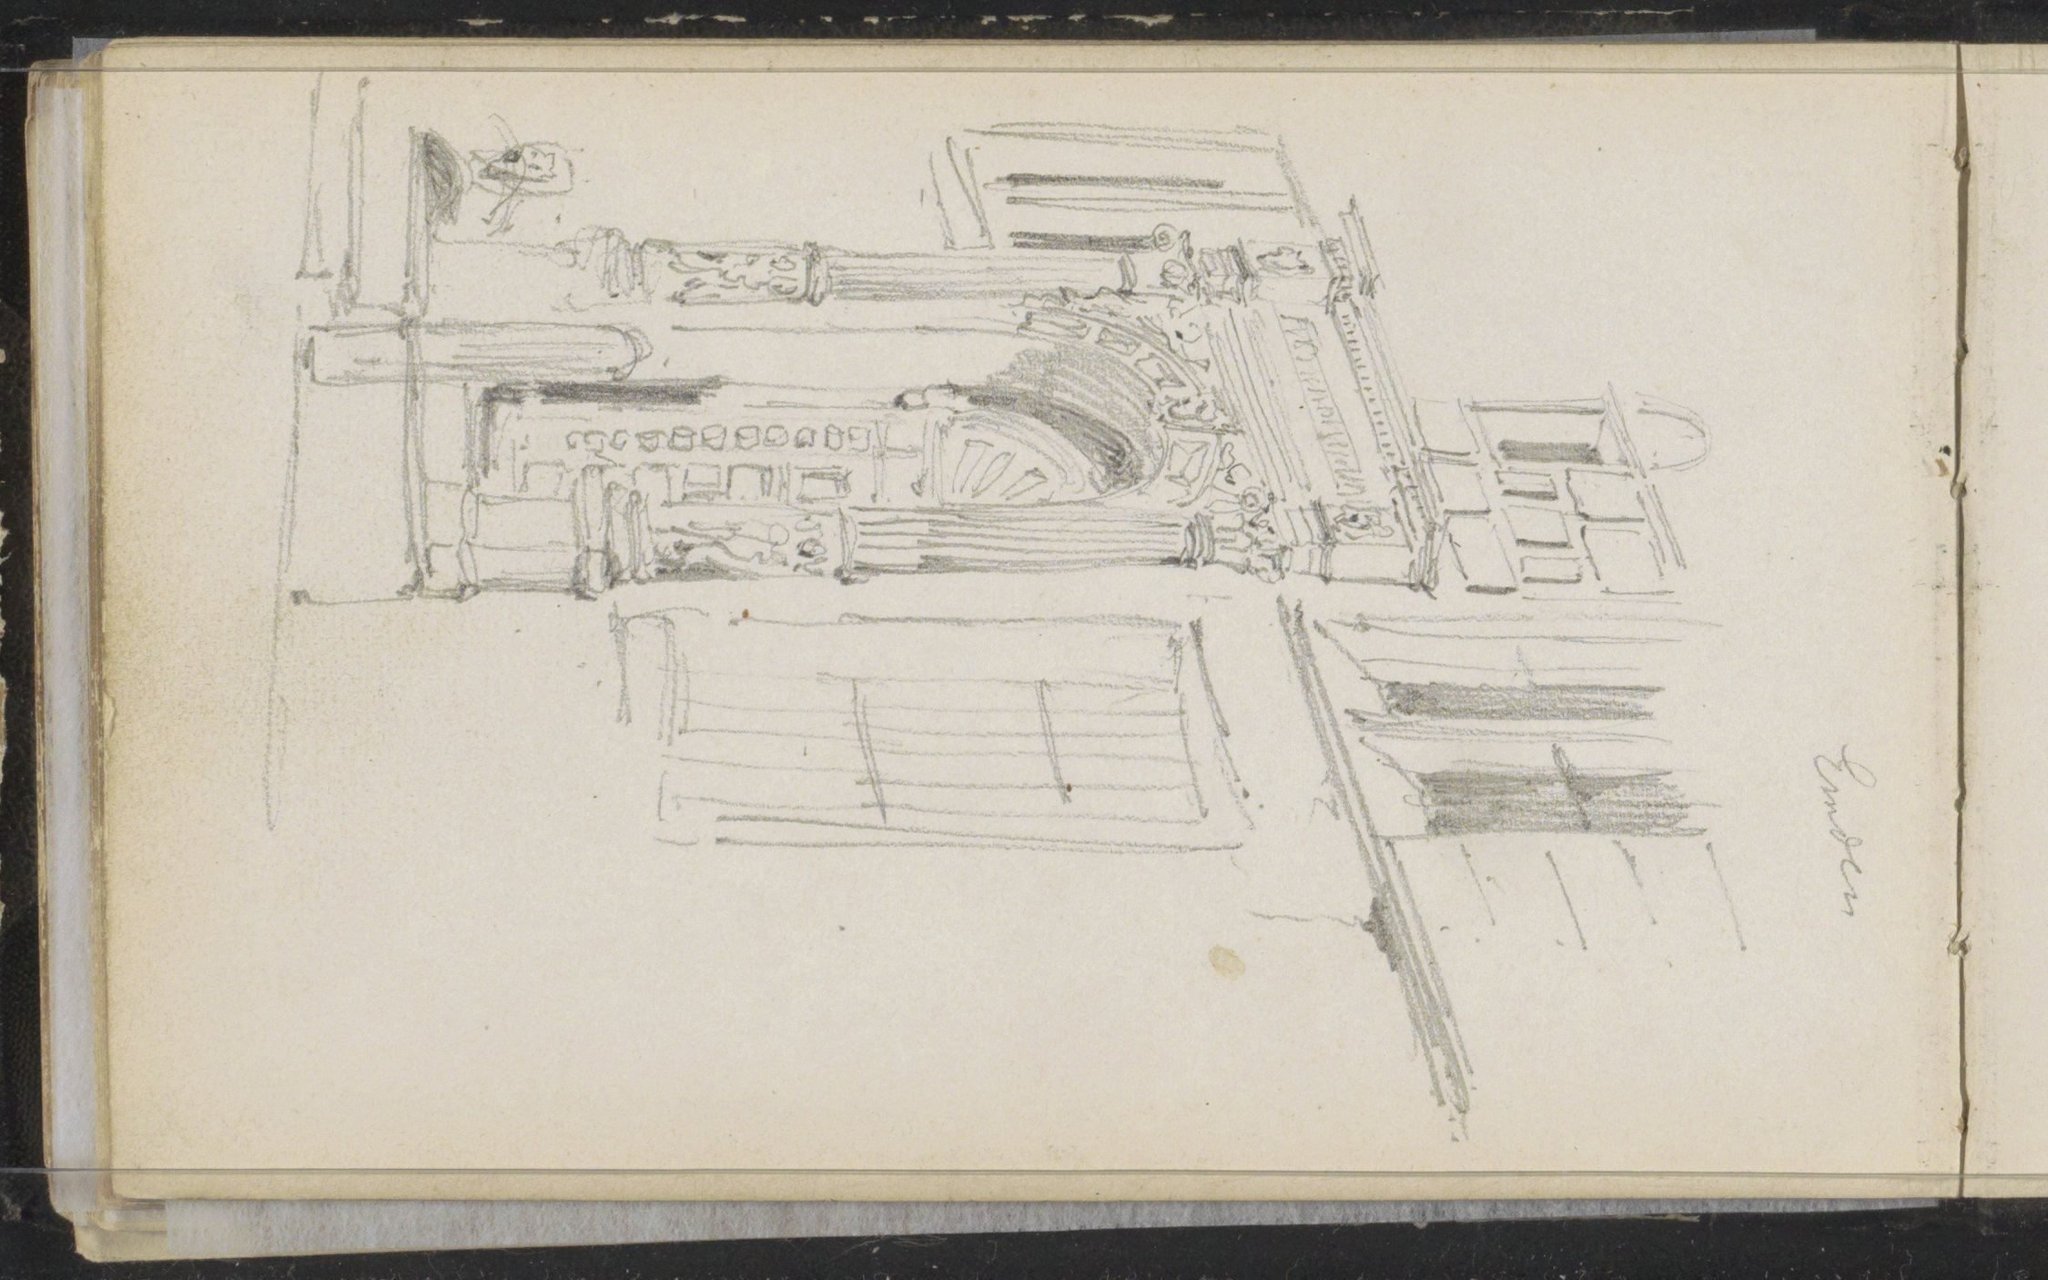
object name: sketchbook leaf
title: Gezicht op het portaal van het Raadhuis in Emden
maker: cornelis springer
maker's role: draughtsman, painter, print maker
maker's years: 1817-1891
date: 1863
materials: paper, pencil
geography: emden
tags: urban housing, front façade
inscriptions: annotation: ‘Emden’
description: Gezicht op het portaal van het Raadhuis in Emden. Blad 53 verso uit een schetsboek met 55 bladen vervaardigd op de Veluwe en in Noord-Duitsland.